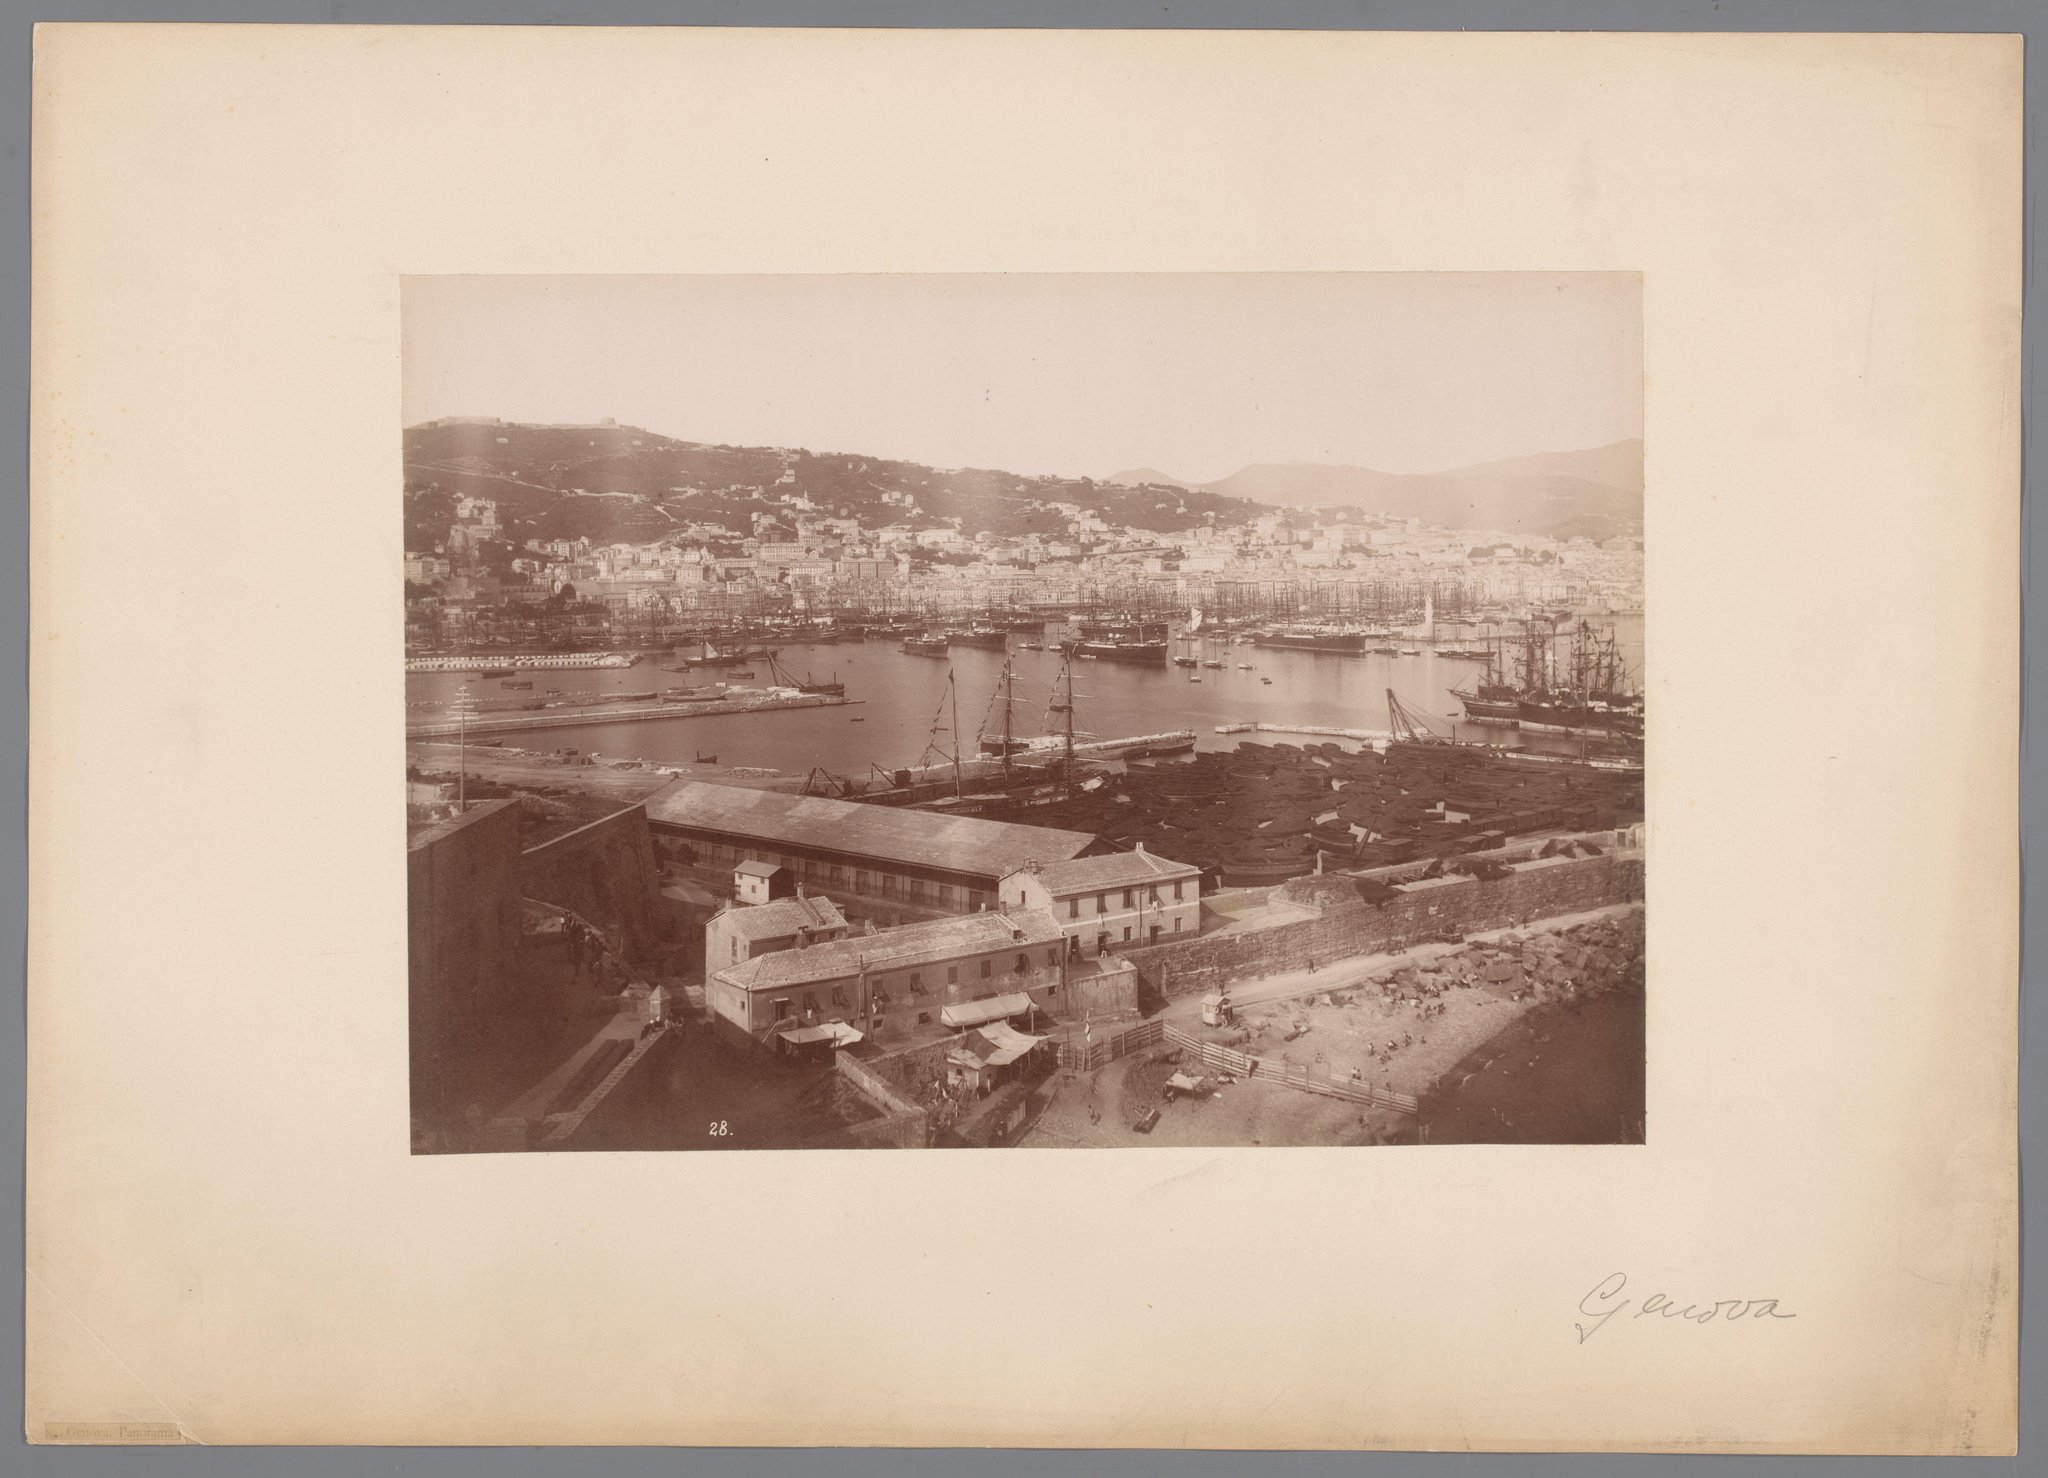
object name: photograph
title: Genova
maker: alfredo noack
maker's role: fotograaf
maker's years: 1833-1895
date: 1858-1893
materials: cardboard, paper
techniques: albumen print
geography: genoa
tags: harbour, ships (in general)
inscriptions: number: ‘28.’, inscription: ‘Genova’, inscription: ‘Noach (t)’, number: ‘27’